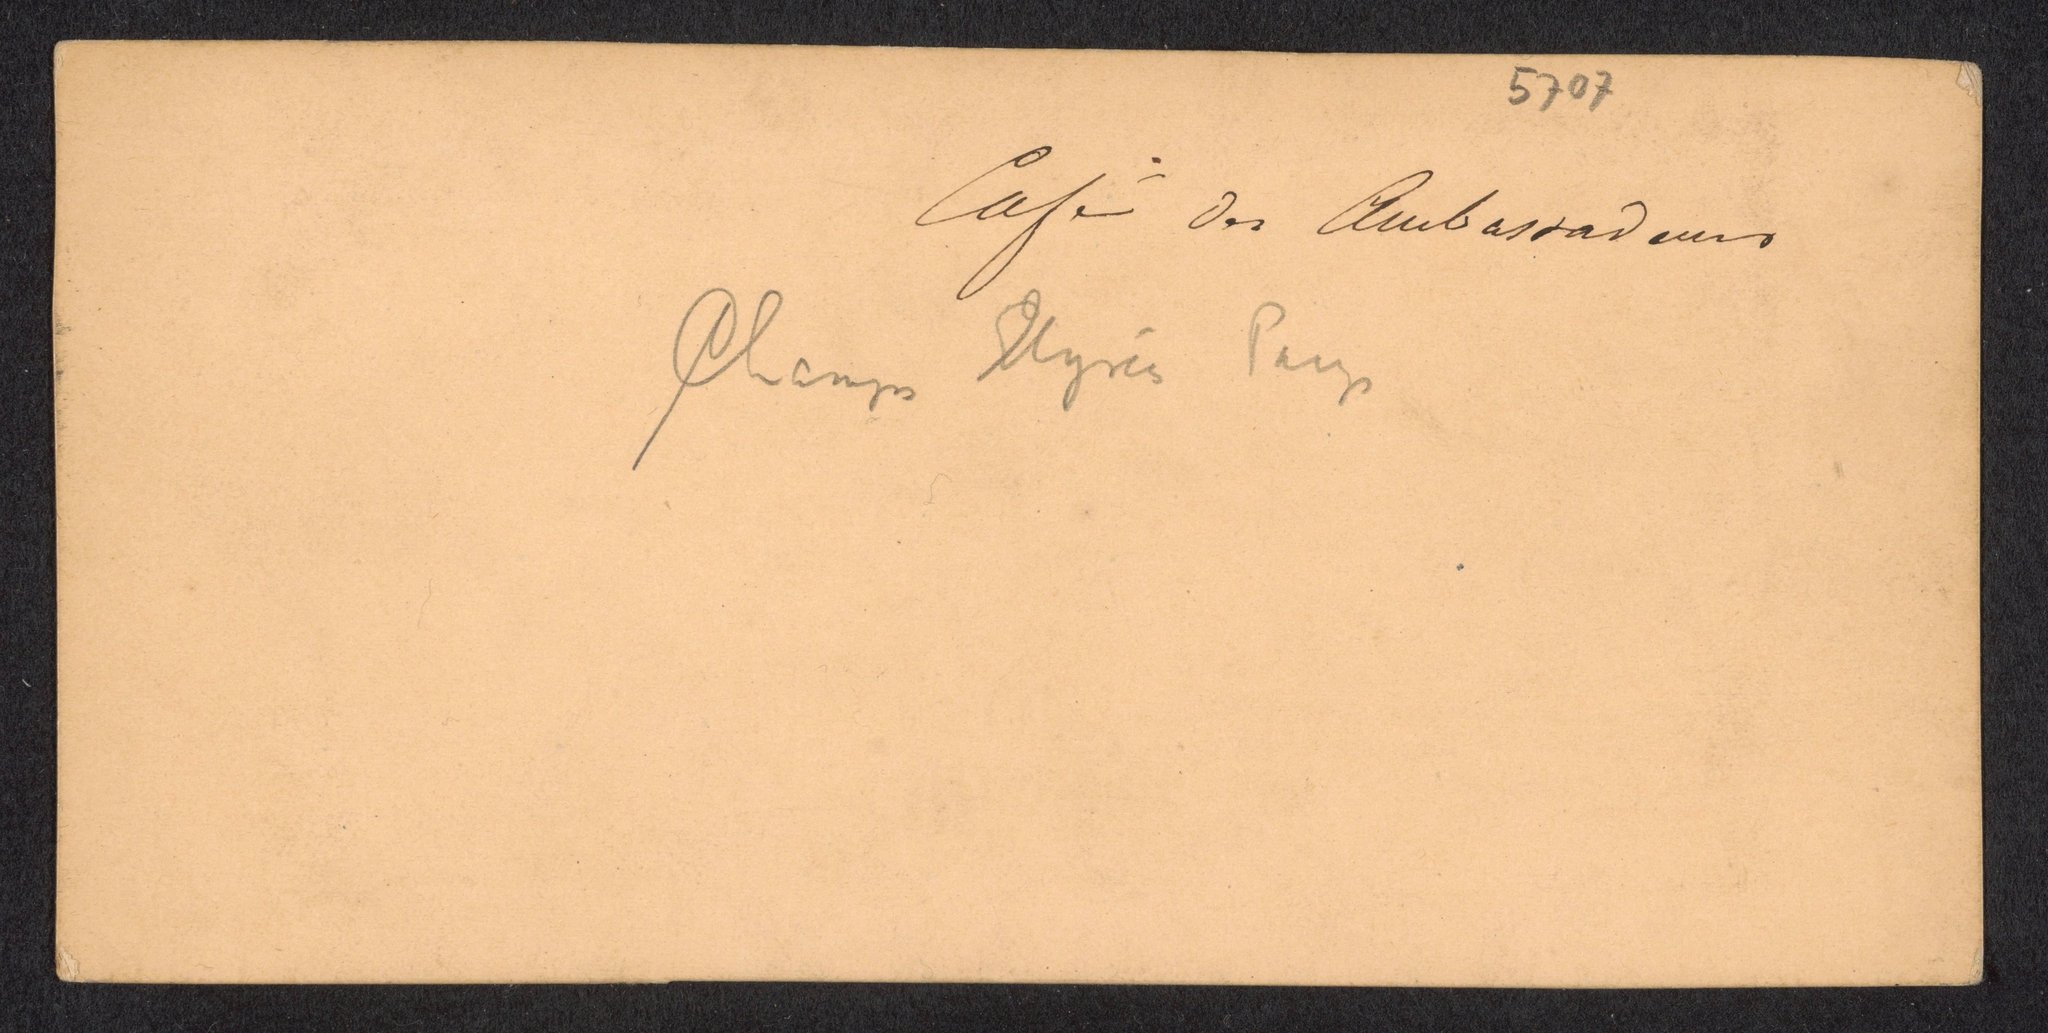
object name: stereograph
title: Gezicht op het Pavillon Ledoyen op de Champs-Élysées in Parijs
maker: Anonymous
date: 1850-1880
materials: cardboard, photographic support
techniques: albumen print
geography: paris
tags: ornamental fountain, restaurant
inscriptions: inscription: ‘Cafe des Ambassadeurs, Champs Elysées Parijs’